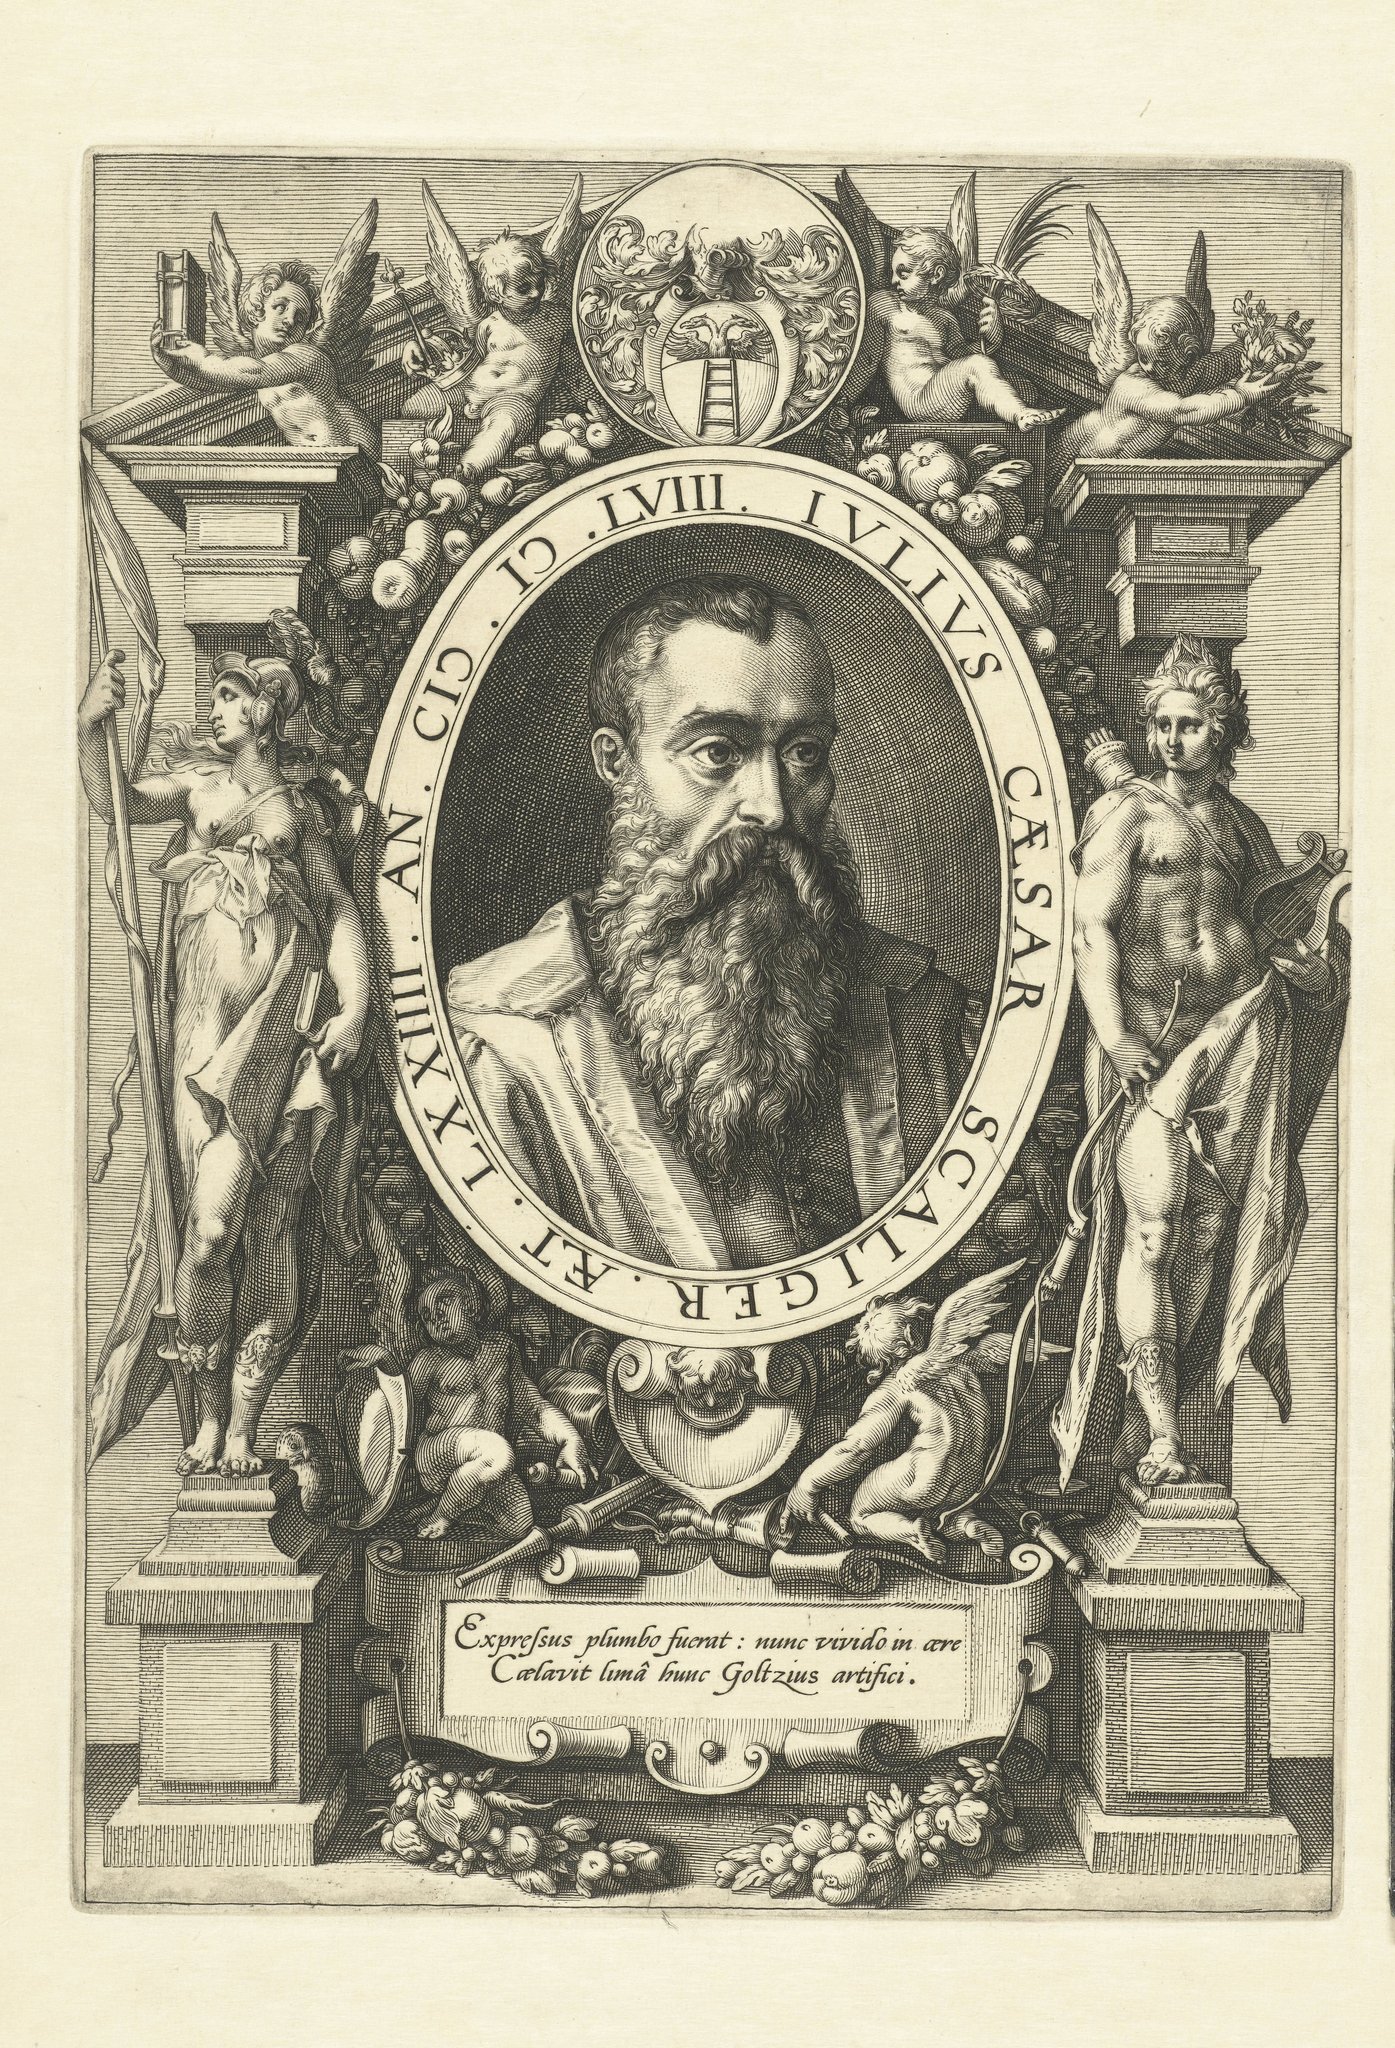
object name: print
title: Portret van Julius Caesar Scaliger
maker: hendrick goltzius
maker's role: draughtsman, painter, print maker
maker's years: 1558-1617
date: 1590-1594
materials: paper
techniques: engraving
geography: haarlem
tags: julius caesar scaliger, philology (+ portrait of scholar, scientist), historical persons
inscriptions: collector's mark: Lugt 2233, signature: ‘Expresus plumbo....Goltzius artifici’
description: Deze gravure werd samen met Goltzius' gravure van de zoon van Julius Caesar Scaliger, Josephus Justus Scaliger (zie nummers/relaties), in opdracht van de Universiteit Leiden vervaardigd in 1592. De universiteit stuurde afdrukken van deze twee prenten naar verschillende geleerden in Europa. Goltzius ontving voor het graveren van de twee platen 200 guldens en nog 11 guldens extra om van elke plaat 500 afdrukken te maken. De platen bevinden zich in de Universiteitsbibliotheek van Leiden. Jacobs, G.